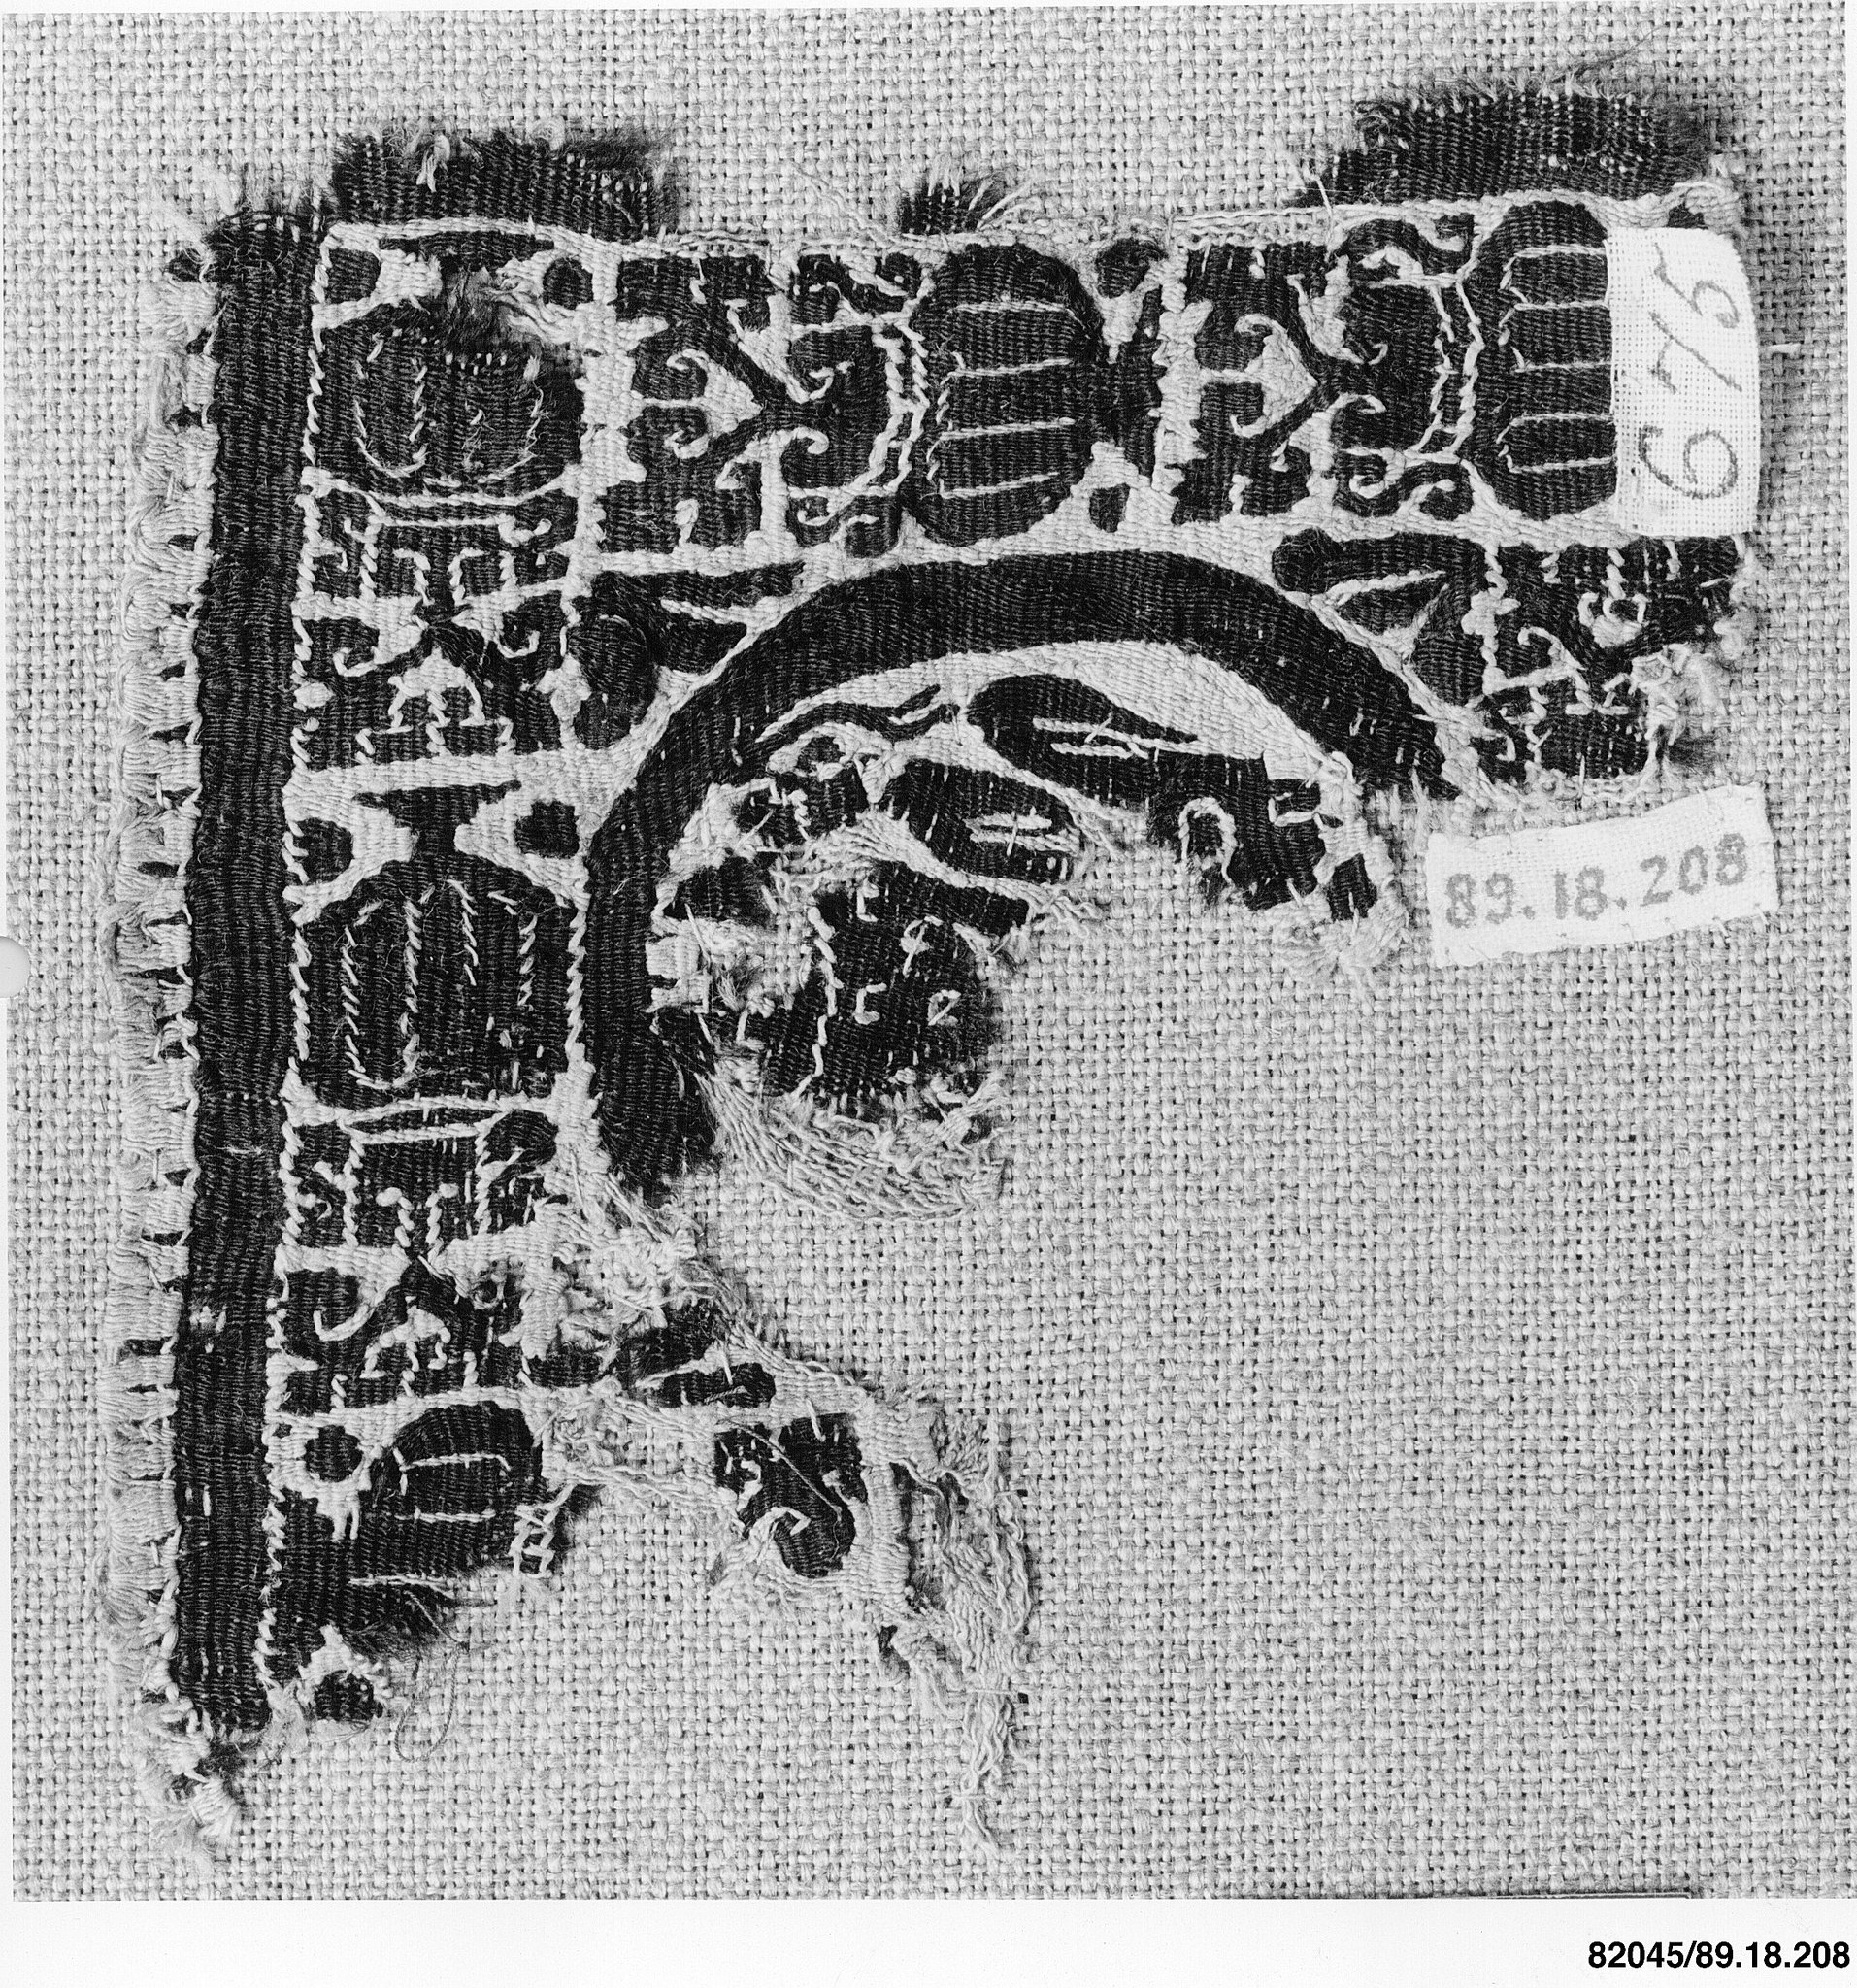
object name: textile fragment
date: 201-400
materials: linen, wool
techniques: weave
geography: egypt